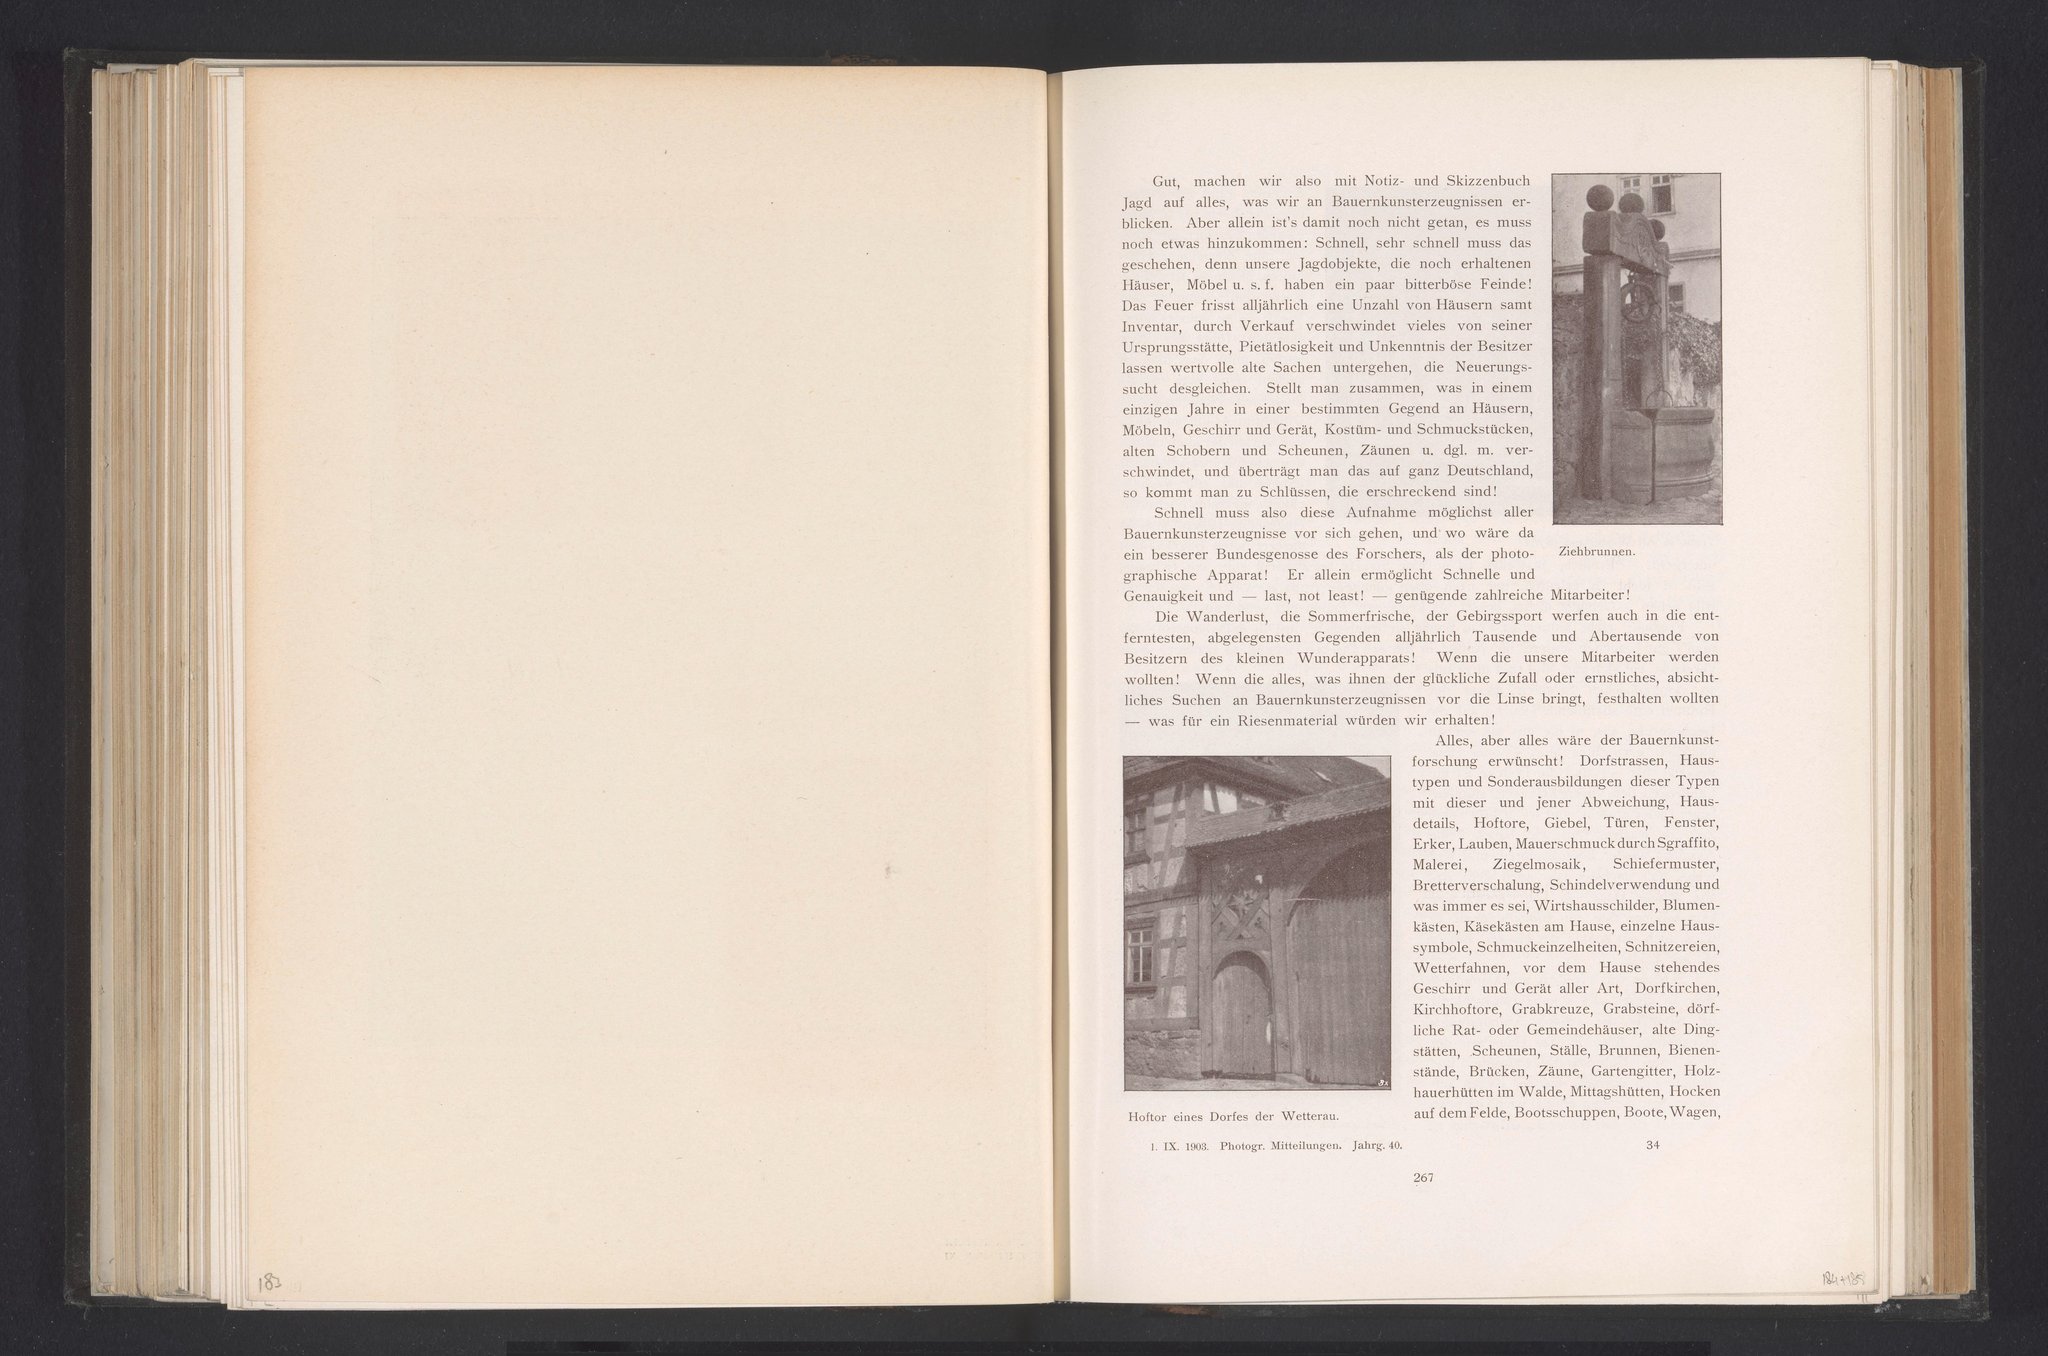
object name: photomechanical print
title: Waterput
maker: Anonymous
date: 1898-1903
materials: paper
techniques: autotype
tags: well